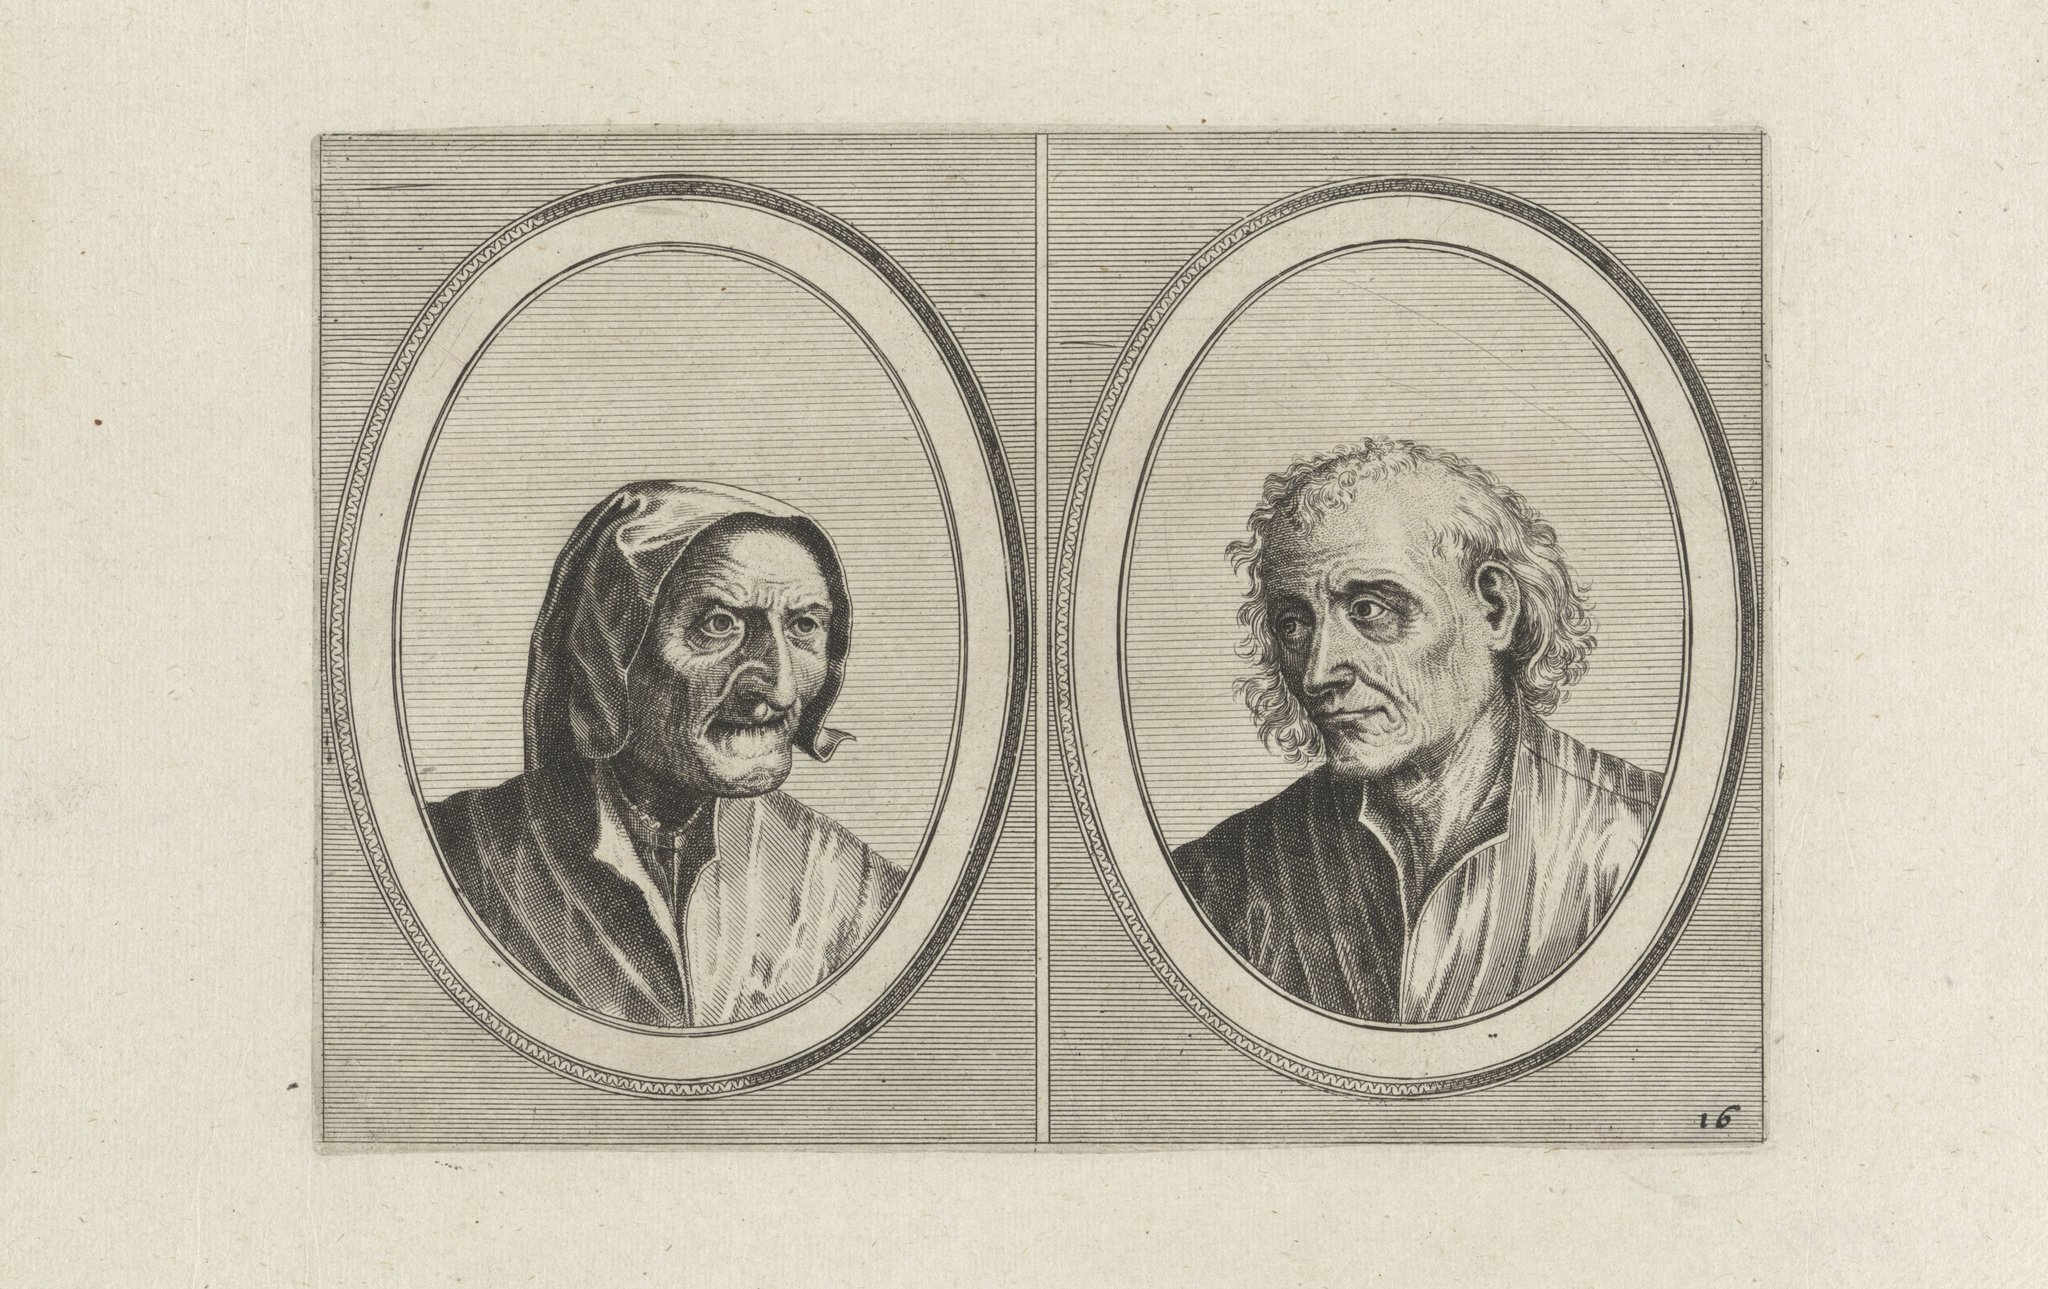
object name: print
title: Foockel Frons-muyl en Pietje Hard-loop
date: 1612-1652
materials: paper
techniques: engraving, etching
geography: amsterdam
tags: head-gear, farmers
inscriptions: collector's mark: Lugt 700, collector's mark: Lugt 240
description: Prent uit een serie van 36 prenten met koppen van boeren en boerinnen.